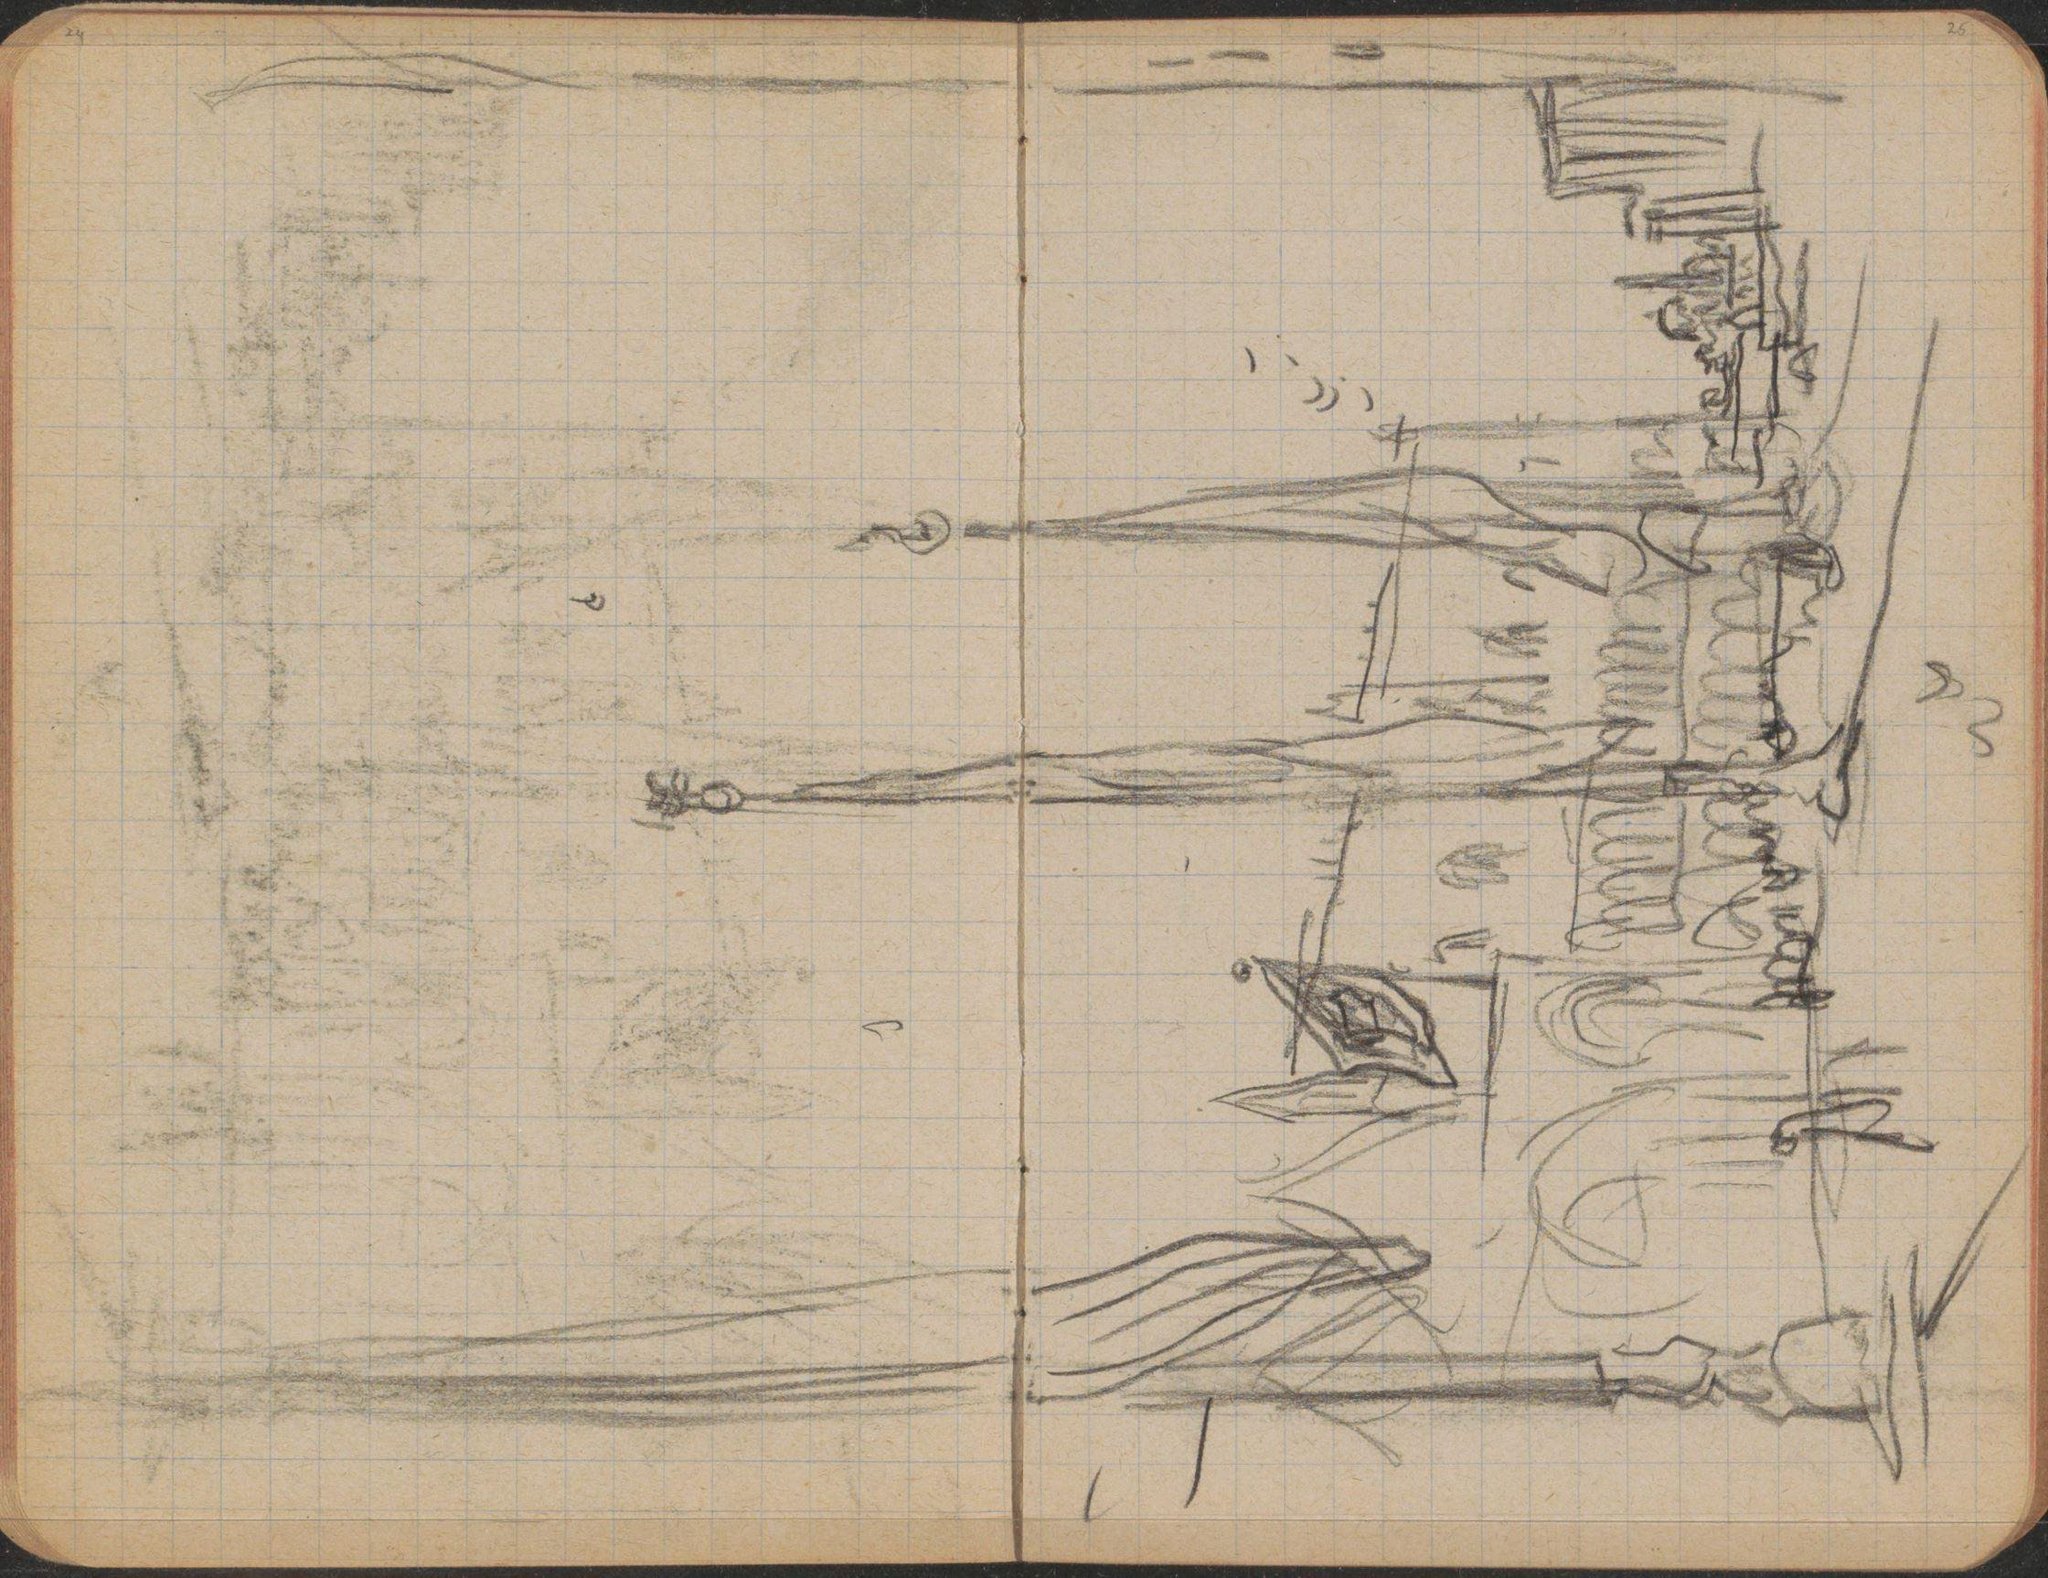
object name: sketchbook leaf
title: San Marco Plein met de Basiliek van San Marco en het Dogenpaleis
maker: marius bauer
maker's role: draughtsman, print maker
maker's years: 1867-1932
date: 1895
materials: chalk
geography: venice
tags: square, place, circus, etc., flags flown from a mast, palace, roman catholic church, street (+ city(-scape) with figures, staffage)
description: Voor de basiliek staan grote vlaggenmasten. Rechts van het Dogenpaleis een doorkijkje naar de San Giorgio Maggiore. Pagina 24 en 25 uit een schetsboek met 28 bladen.